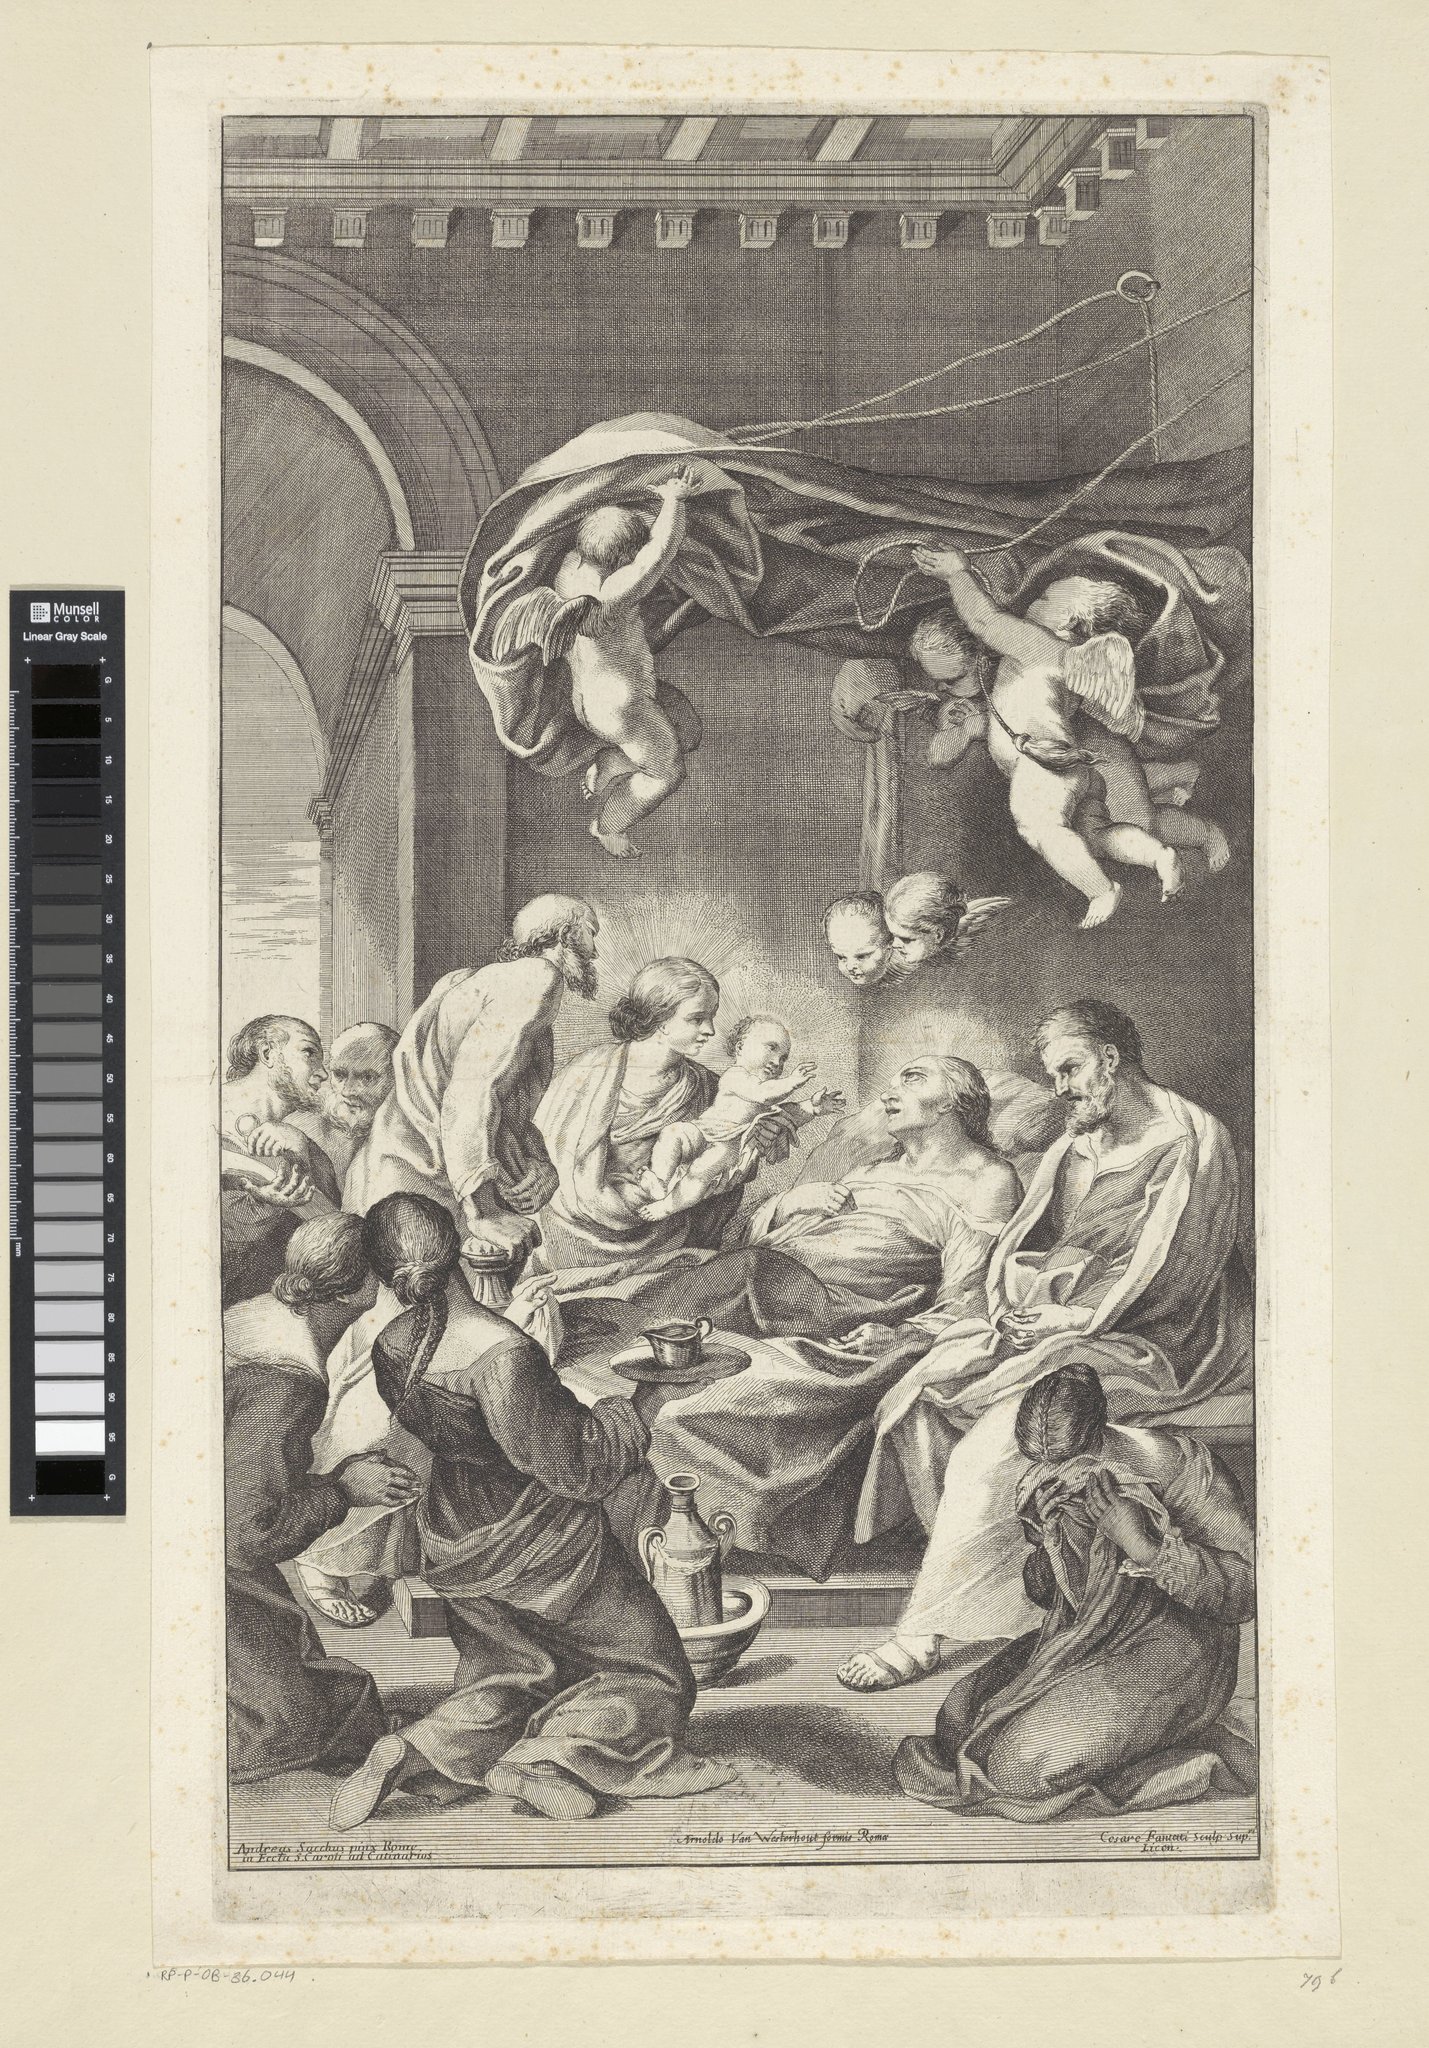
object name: print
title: Dood van H. Anna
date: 1675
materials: paper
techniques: engraving, etching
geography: rome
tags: death of anna, usually mary and christ present, cupids: 'amores', 'amoretti', 'putti'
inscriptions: collector's mark: Lugt 240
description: Maria staat met het Christuskind in haar armen naast het bed van een zieke man. Christus strekt zijn armen uit naar de man. Rond het bed zitten verschillende andere figuren die de zieke man komen bezoeken. Boven het bed zweven cherubijnen en putti.